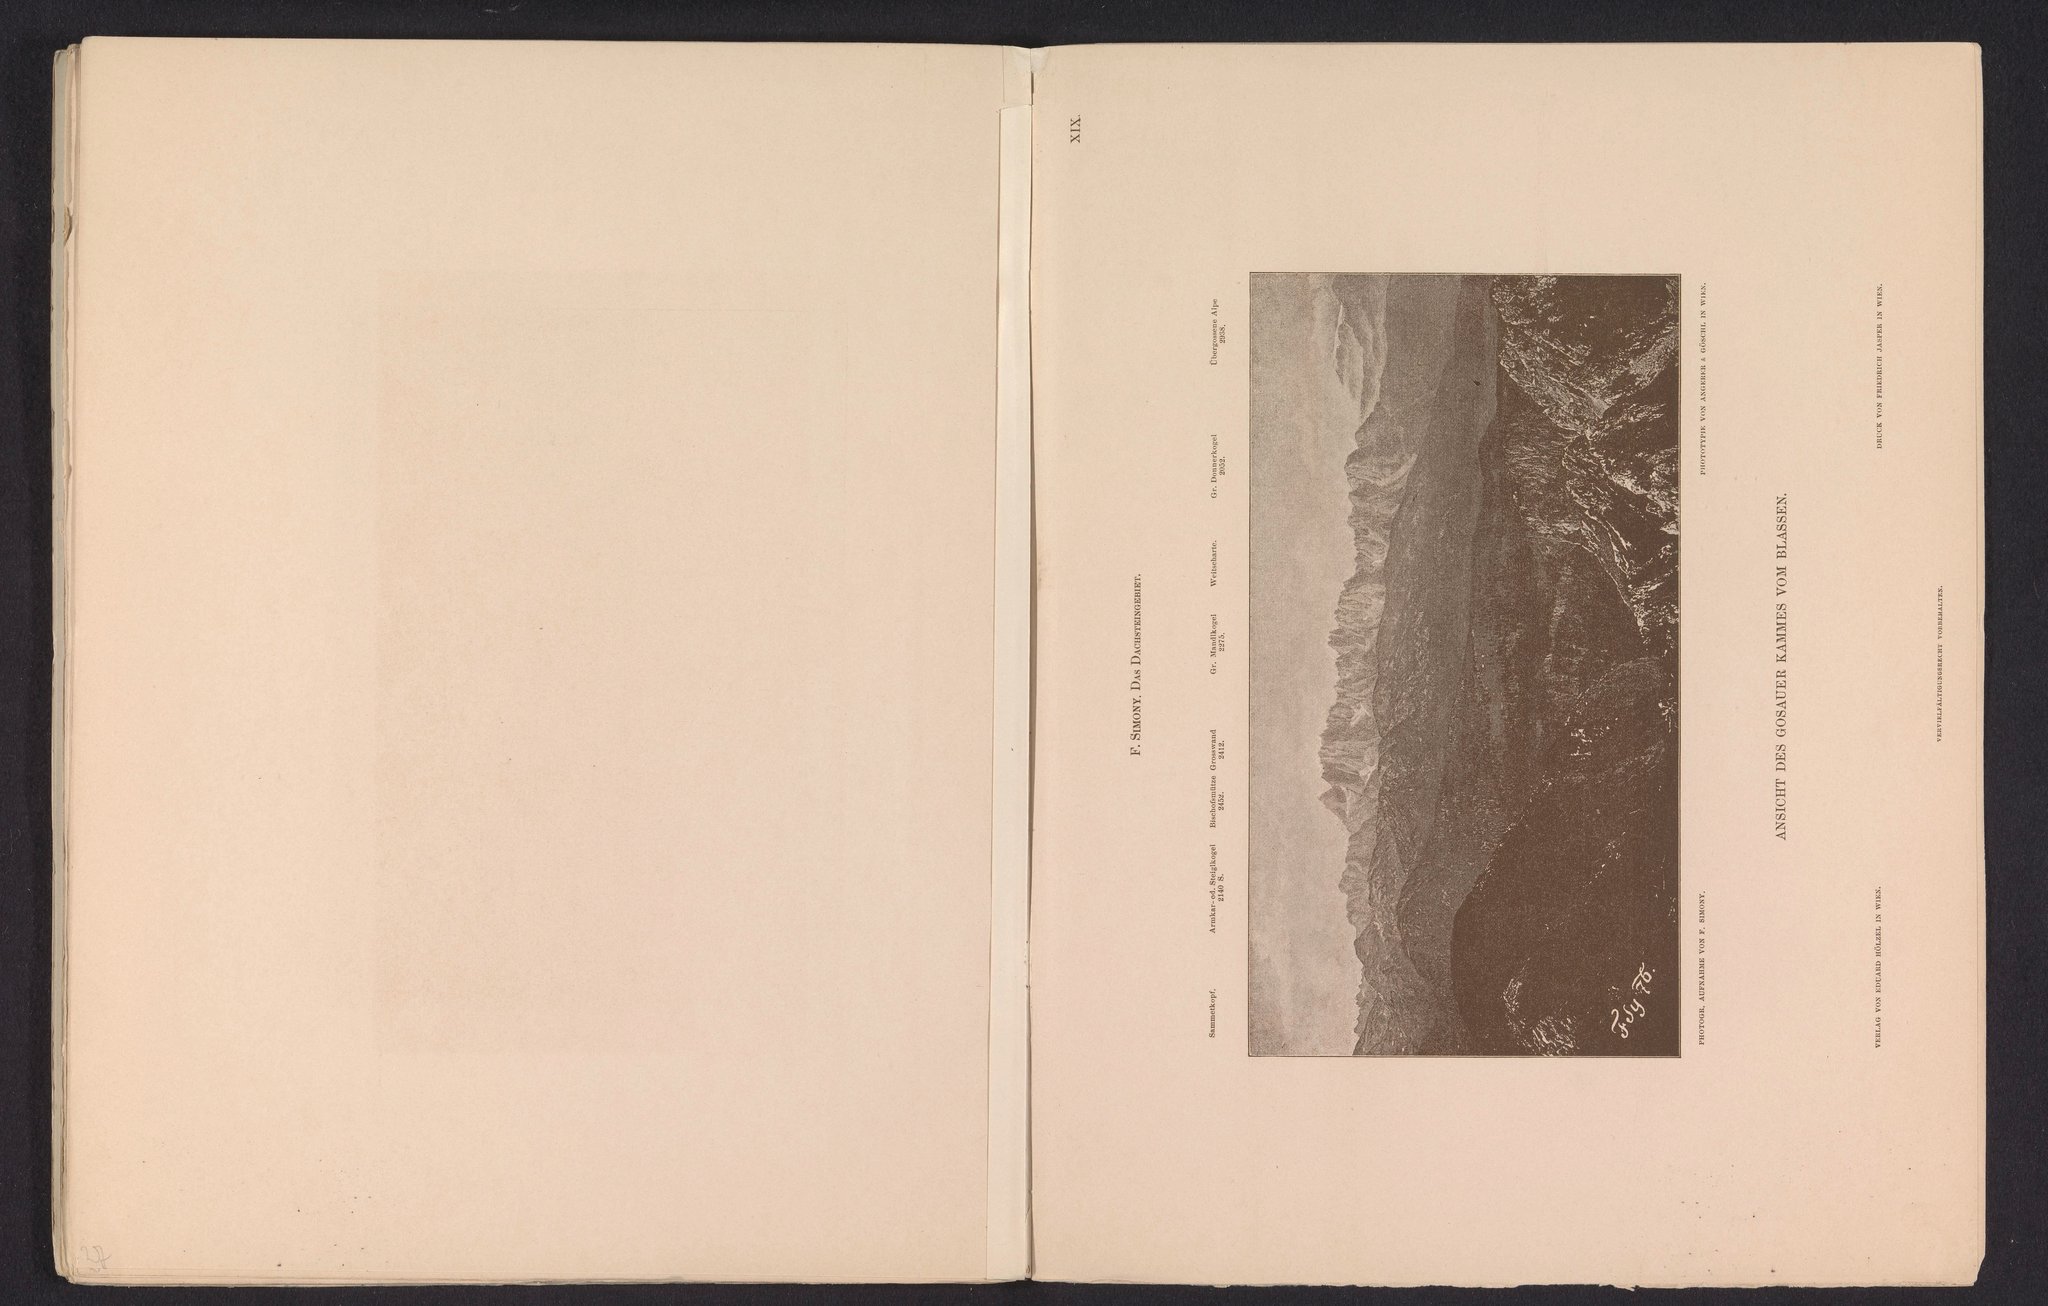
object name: photomechanical print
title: Gezicht op de Gosaukamm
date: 1876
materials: paper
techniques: autotype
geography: salzburg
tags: city-view in general; 'veduta'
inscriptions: number: ‘XIX.’